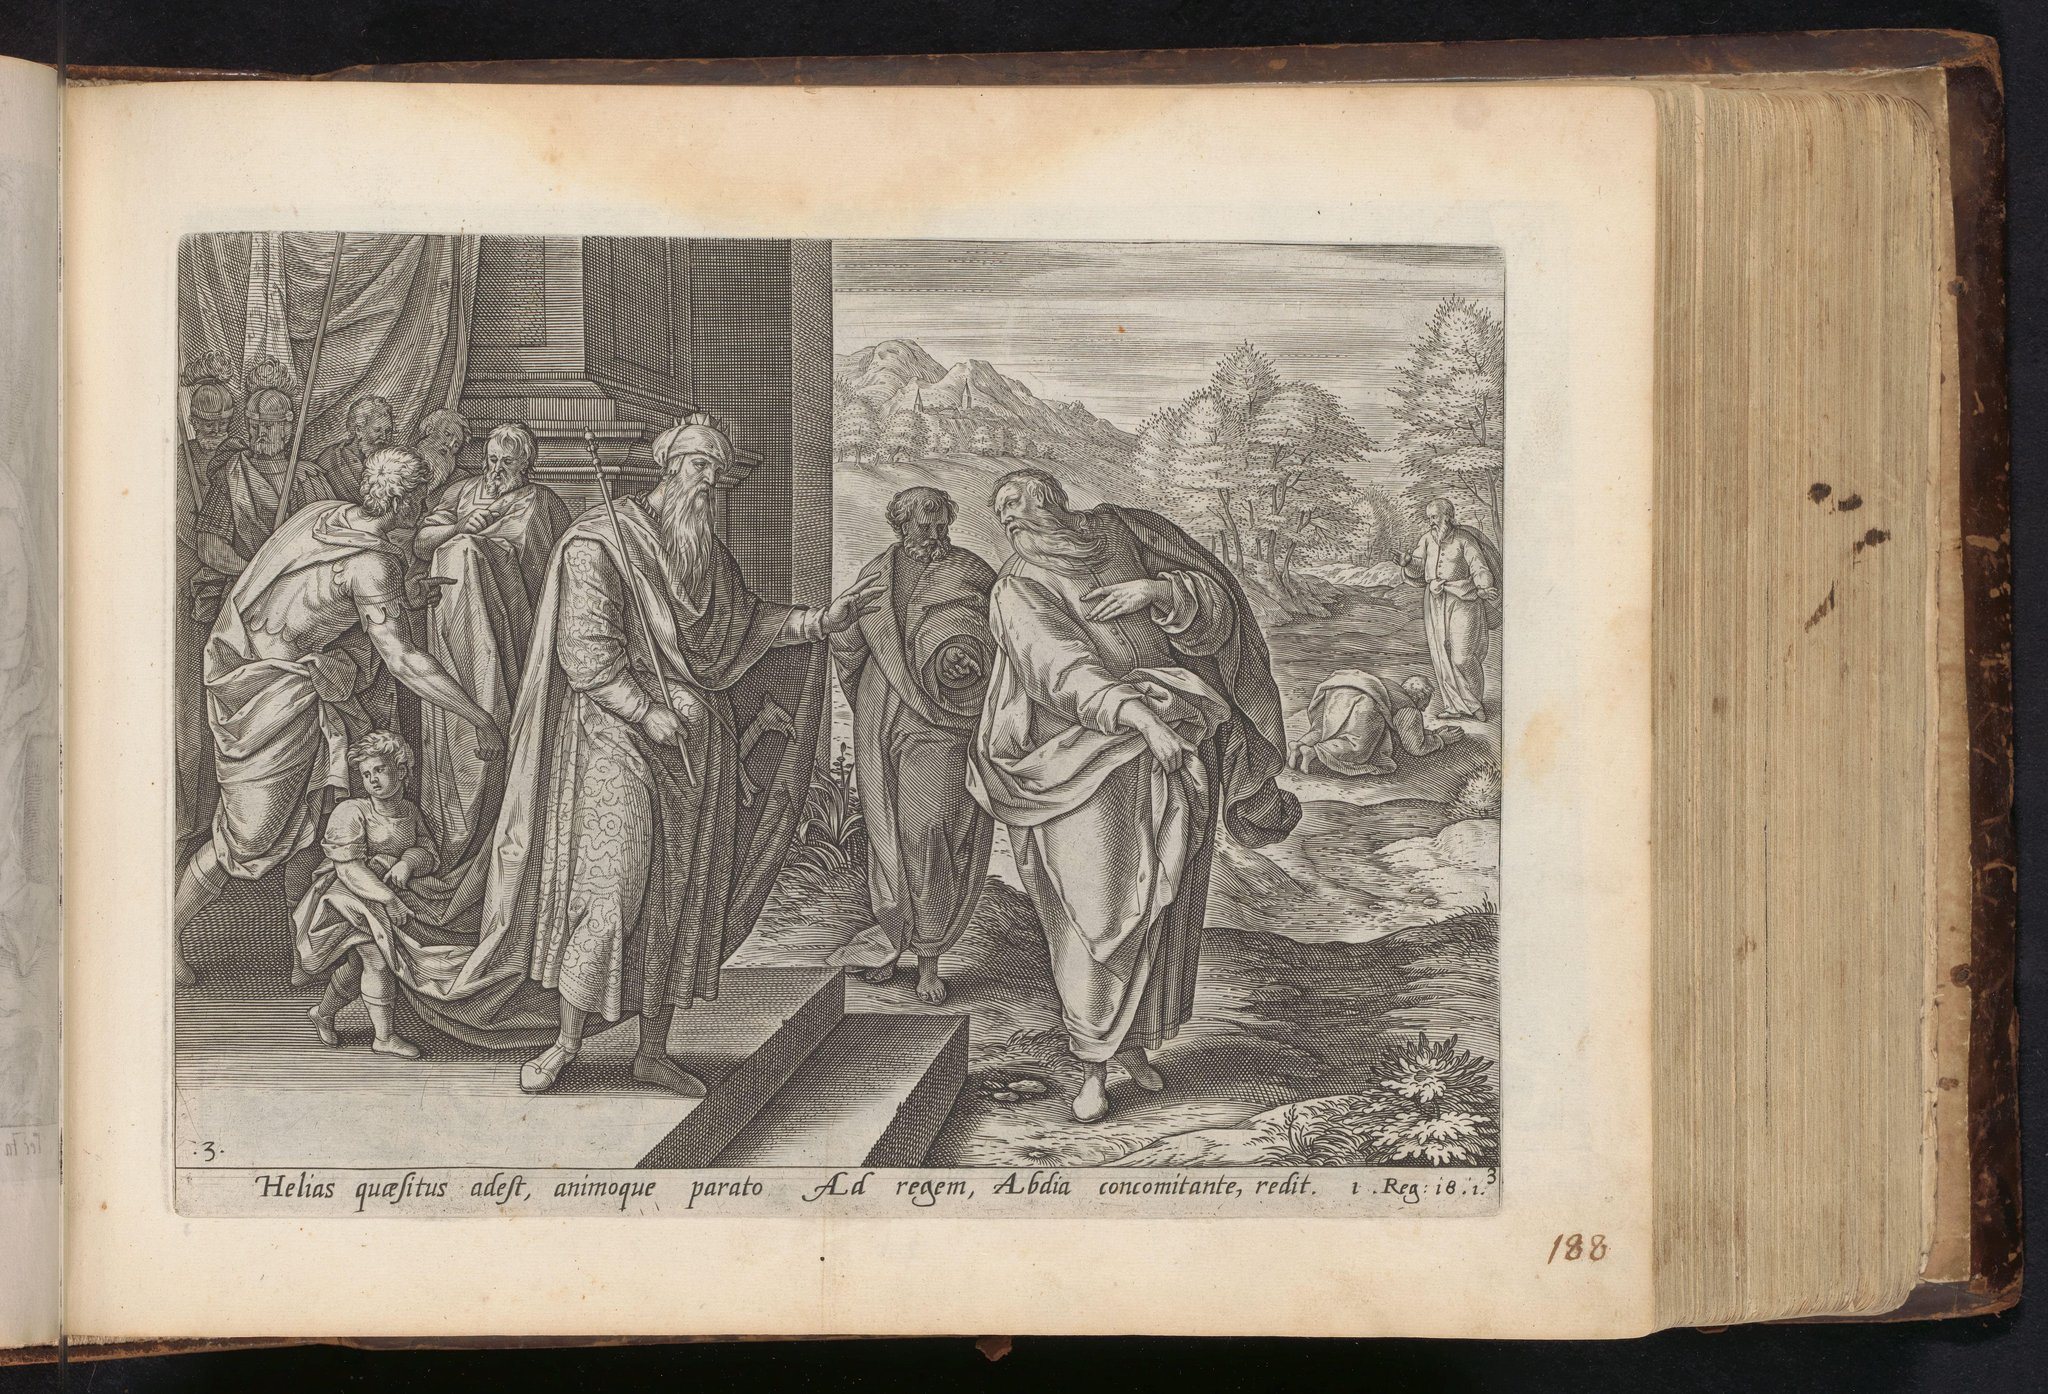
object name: album leaf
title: Gheschiedenissen in Israel, Van Achab en Elias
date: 1579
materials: paper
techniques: engraving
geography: amsterdam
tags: on his way obadiah meets elijah who commands him to summon the king, ahab is reproved by elijah and asked to gather the priests of baal on mount carmel for a contest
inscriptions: number: ‘188’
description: De profeet Elia is door Obadja, hofmeester van koning Achab, bij de koning gebracht; deze spreekt Elia aan met de woorden: 'Bent u het, Elia? U, die Israël in het ongeluk hebt gestort?'. Hierop legt Elia uit dat de koning zelf zijn volk in het ongeluk heeft gestort door de verkeerde goden te vereren. Op de achtergrond rechts is te zien hoe Obadja, zodra hij Elia herkende, voor hem boog. Onder de voorstelling een verwijzing in het Latijn naar de Bijbeltekst in 1 Kon. 18:1. Deze prent maakt deel uit van een album.